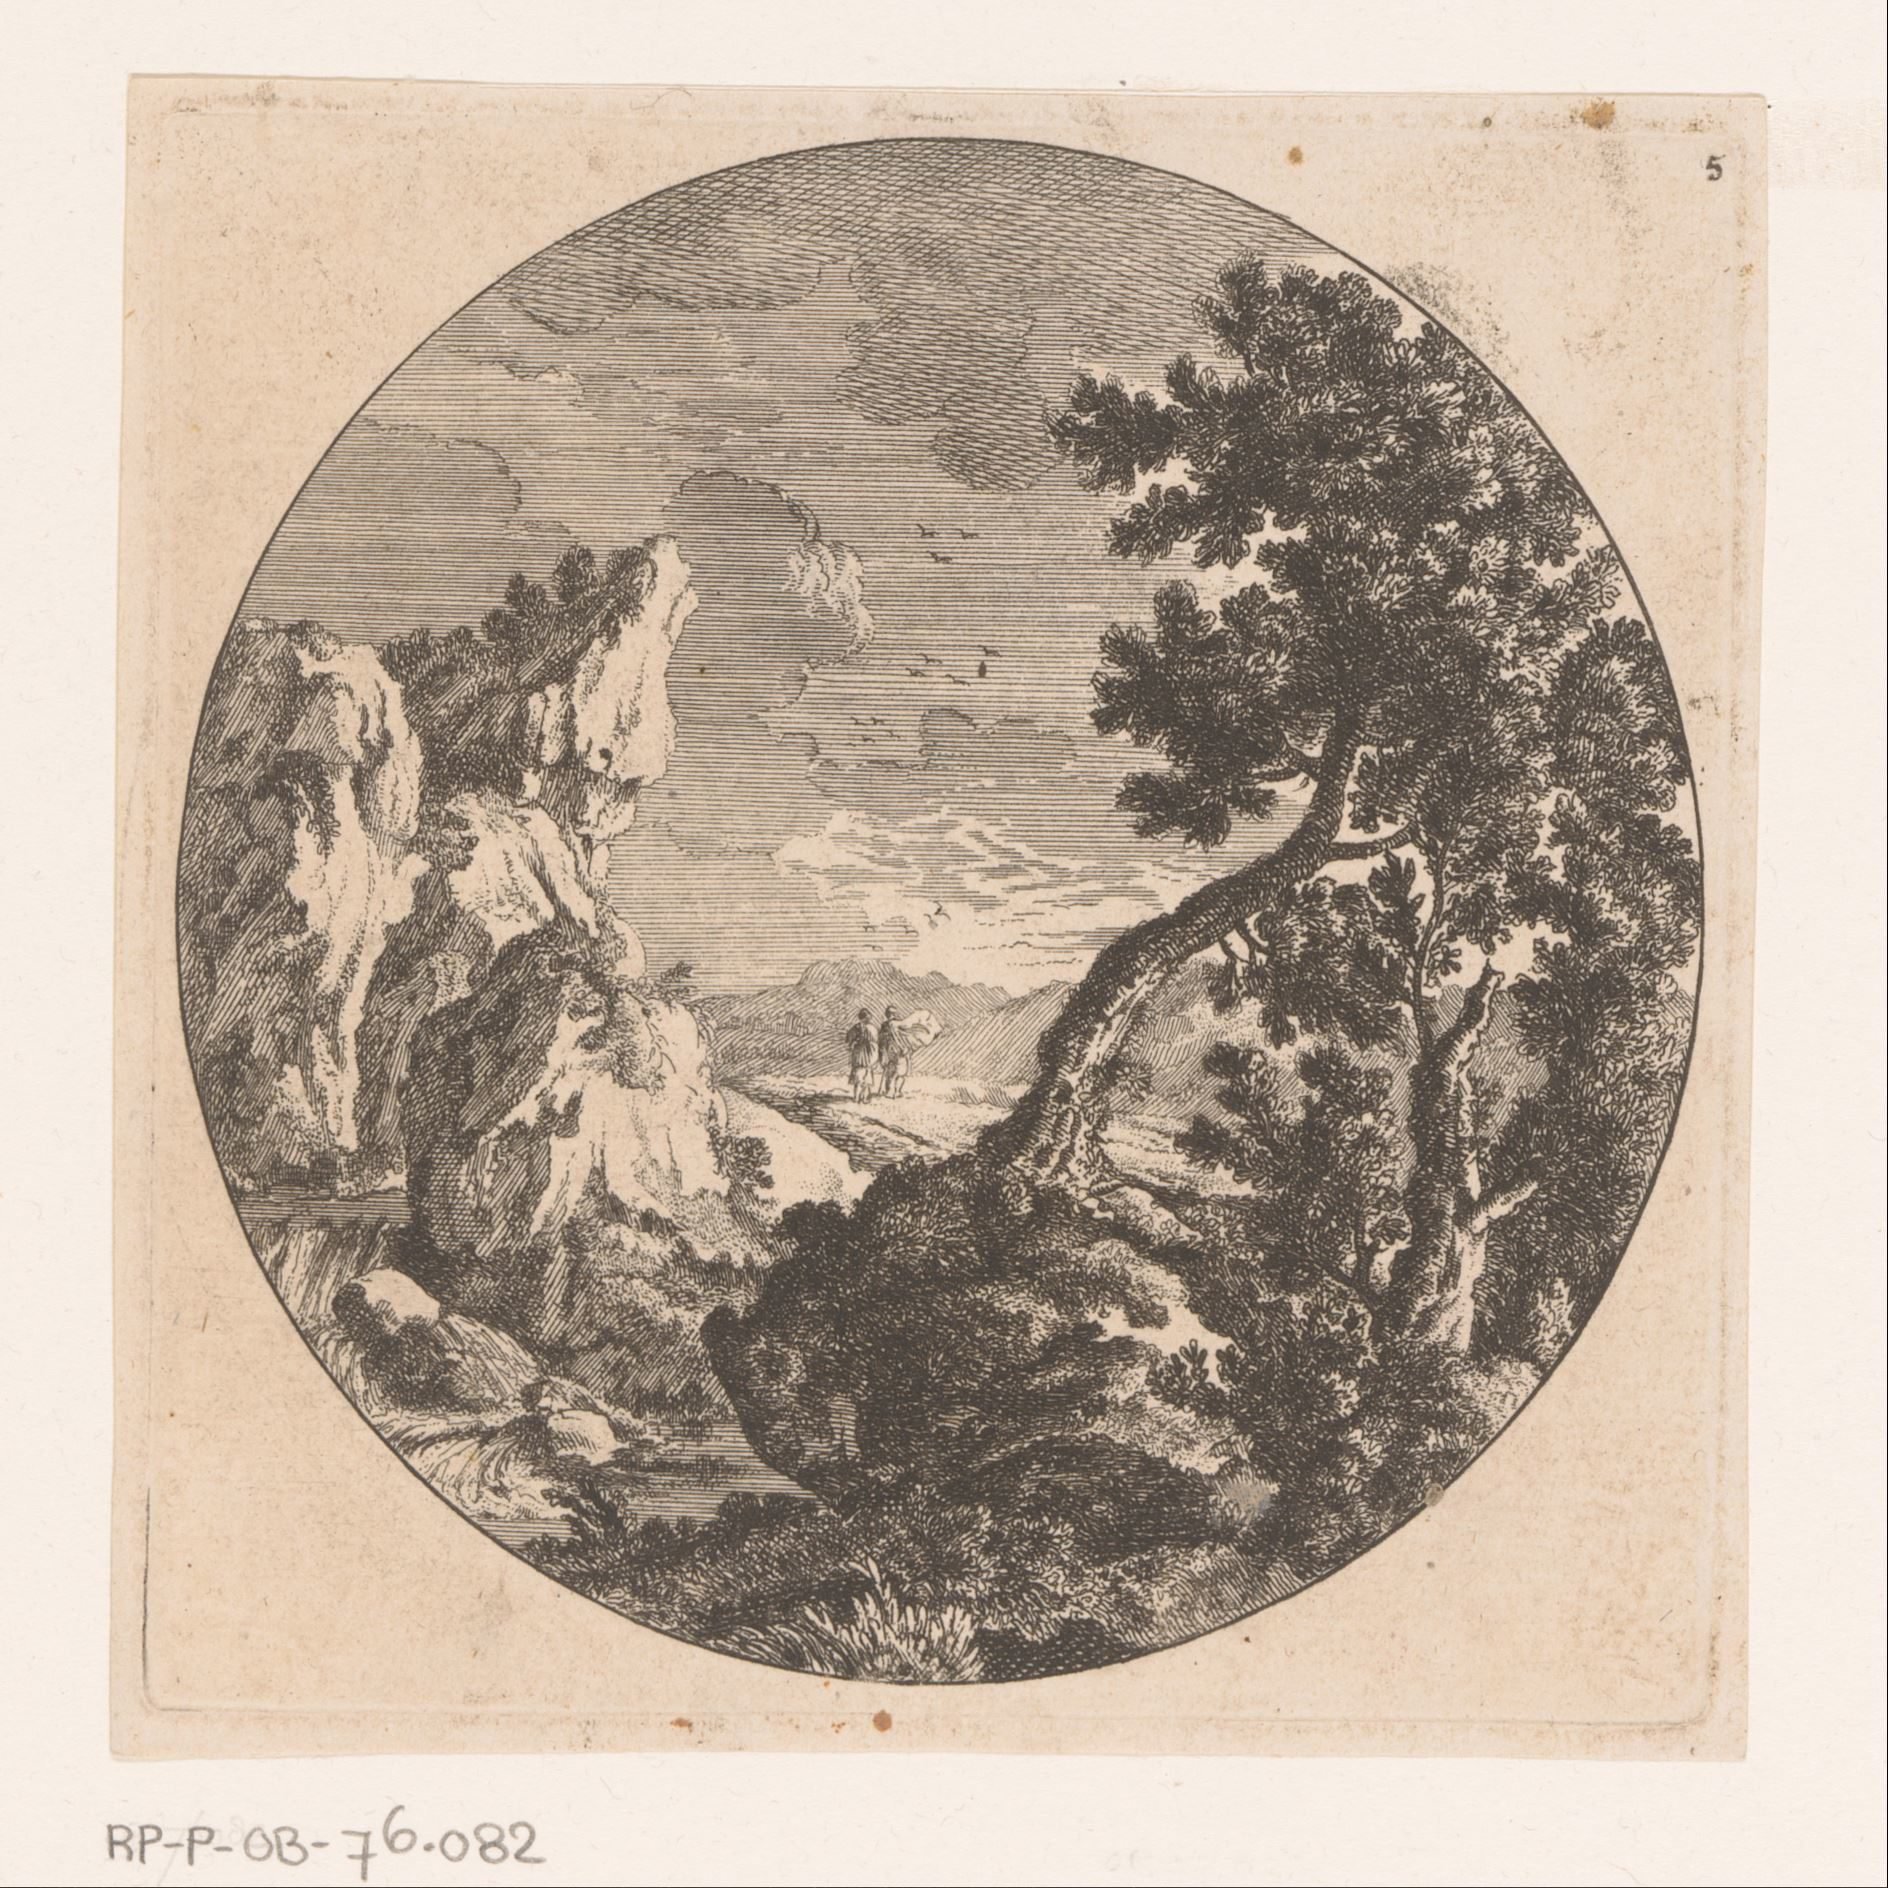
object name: print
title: Landschap met rotsen en twee wandelaars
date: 1613-1695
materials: paper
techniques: etching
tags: rocks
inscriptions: collector's mark: Lugt 240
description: Prenten met het signatuur 'Perelle' kunnen zowel door vader Gabriel als door zonen Nicolas en Adam gemaakt zijn.